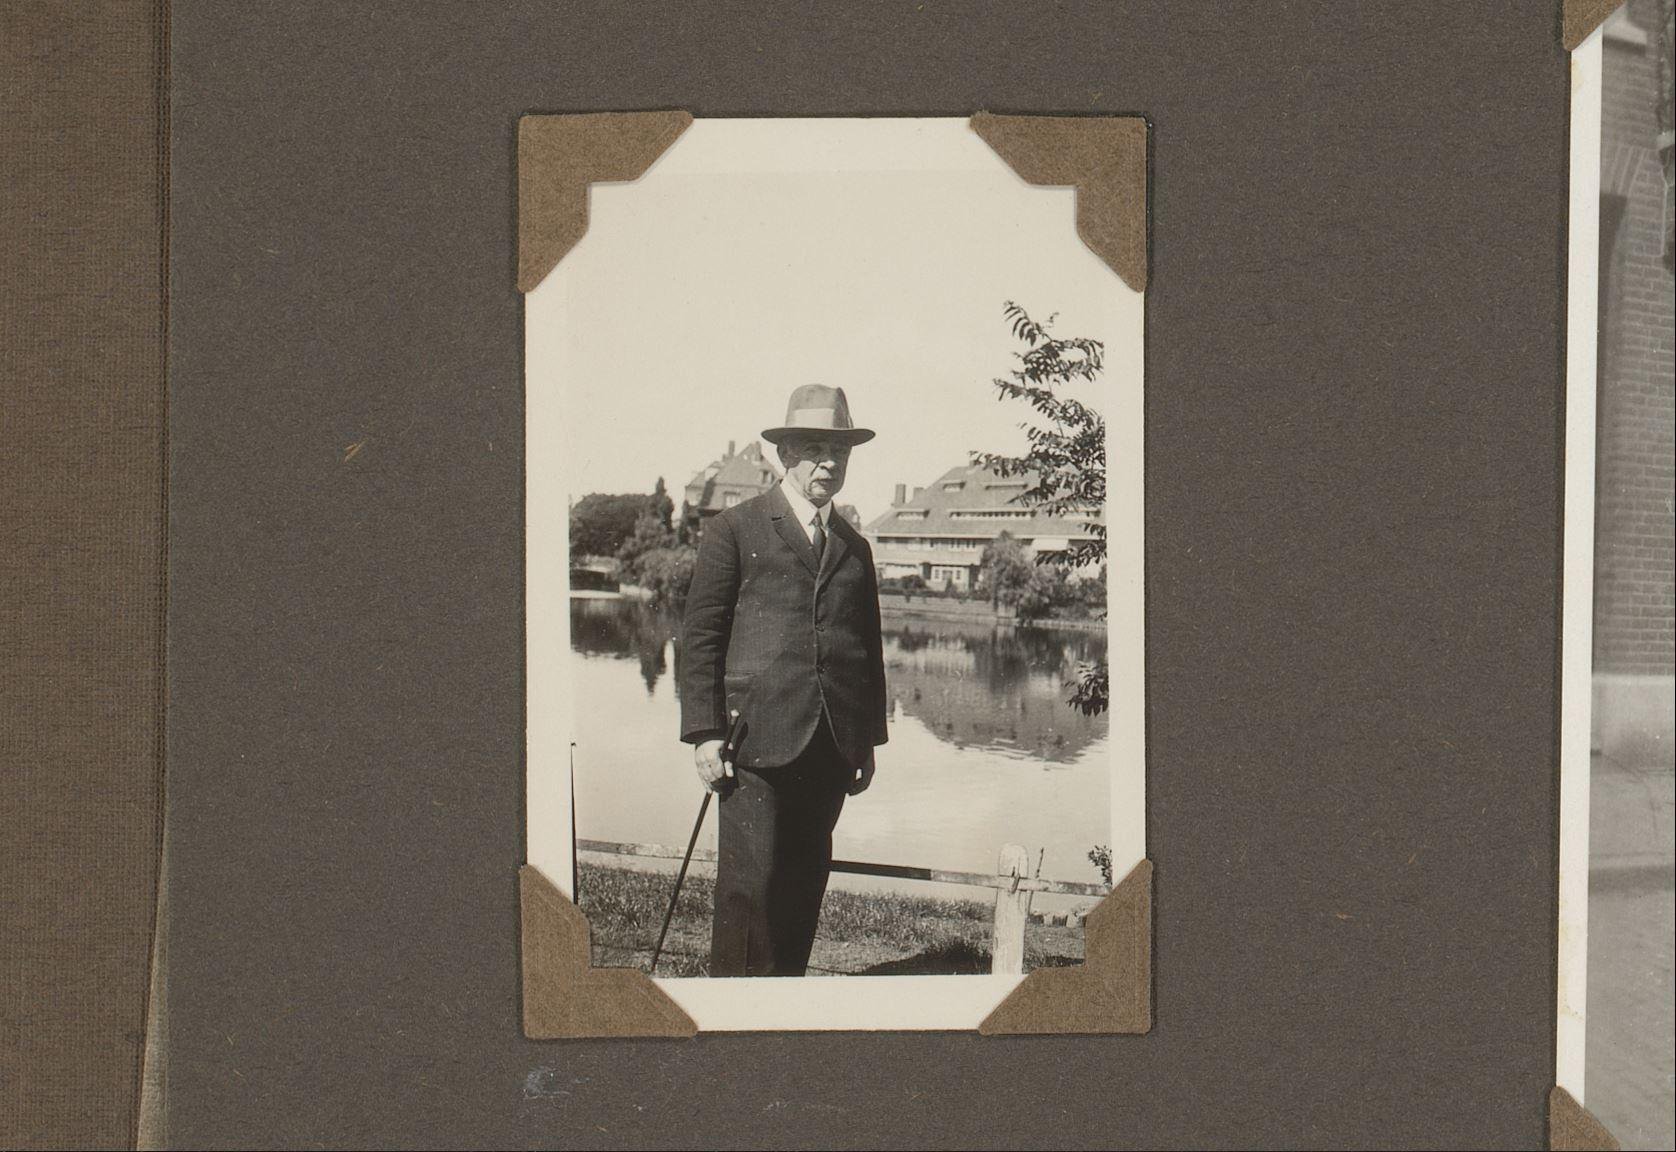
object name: photograph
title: Portret van een man met hoed en wandelstok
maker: Anonymous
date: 1920-1930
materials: photographic support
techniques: gelatin silver print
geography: netherlands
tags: walking-stick, staff, adult man, historical persons, head-gear: hat